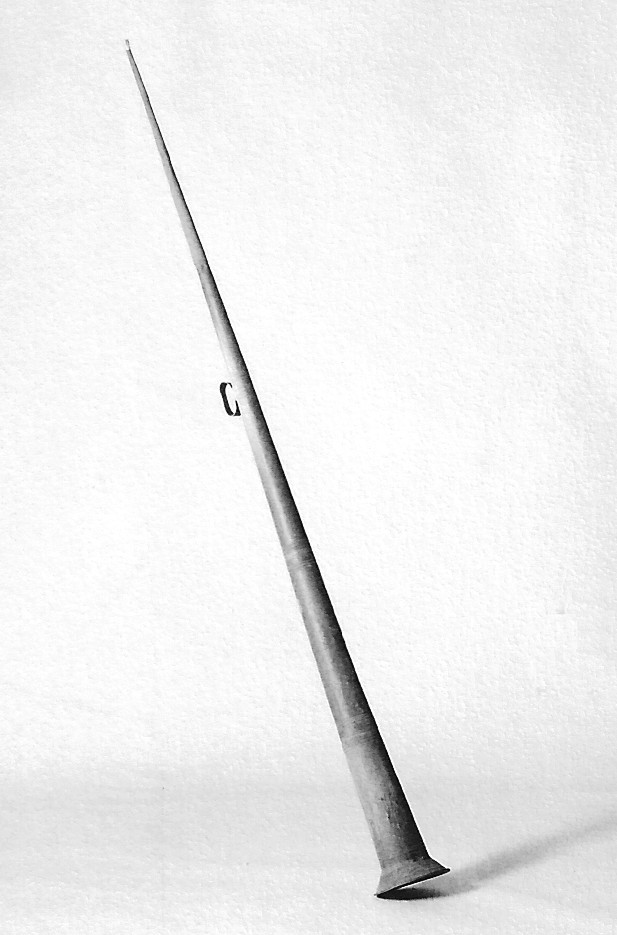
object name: coach horn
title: Coach Horn (?)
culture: american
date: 1801-1833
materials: iron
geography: united states